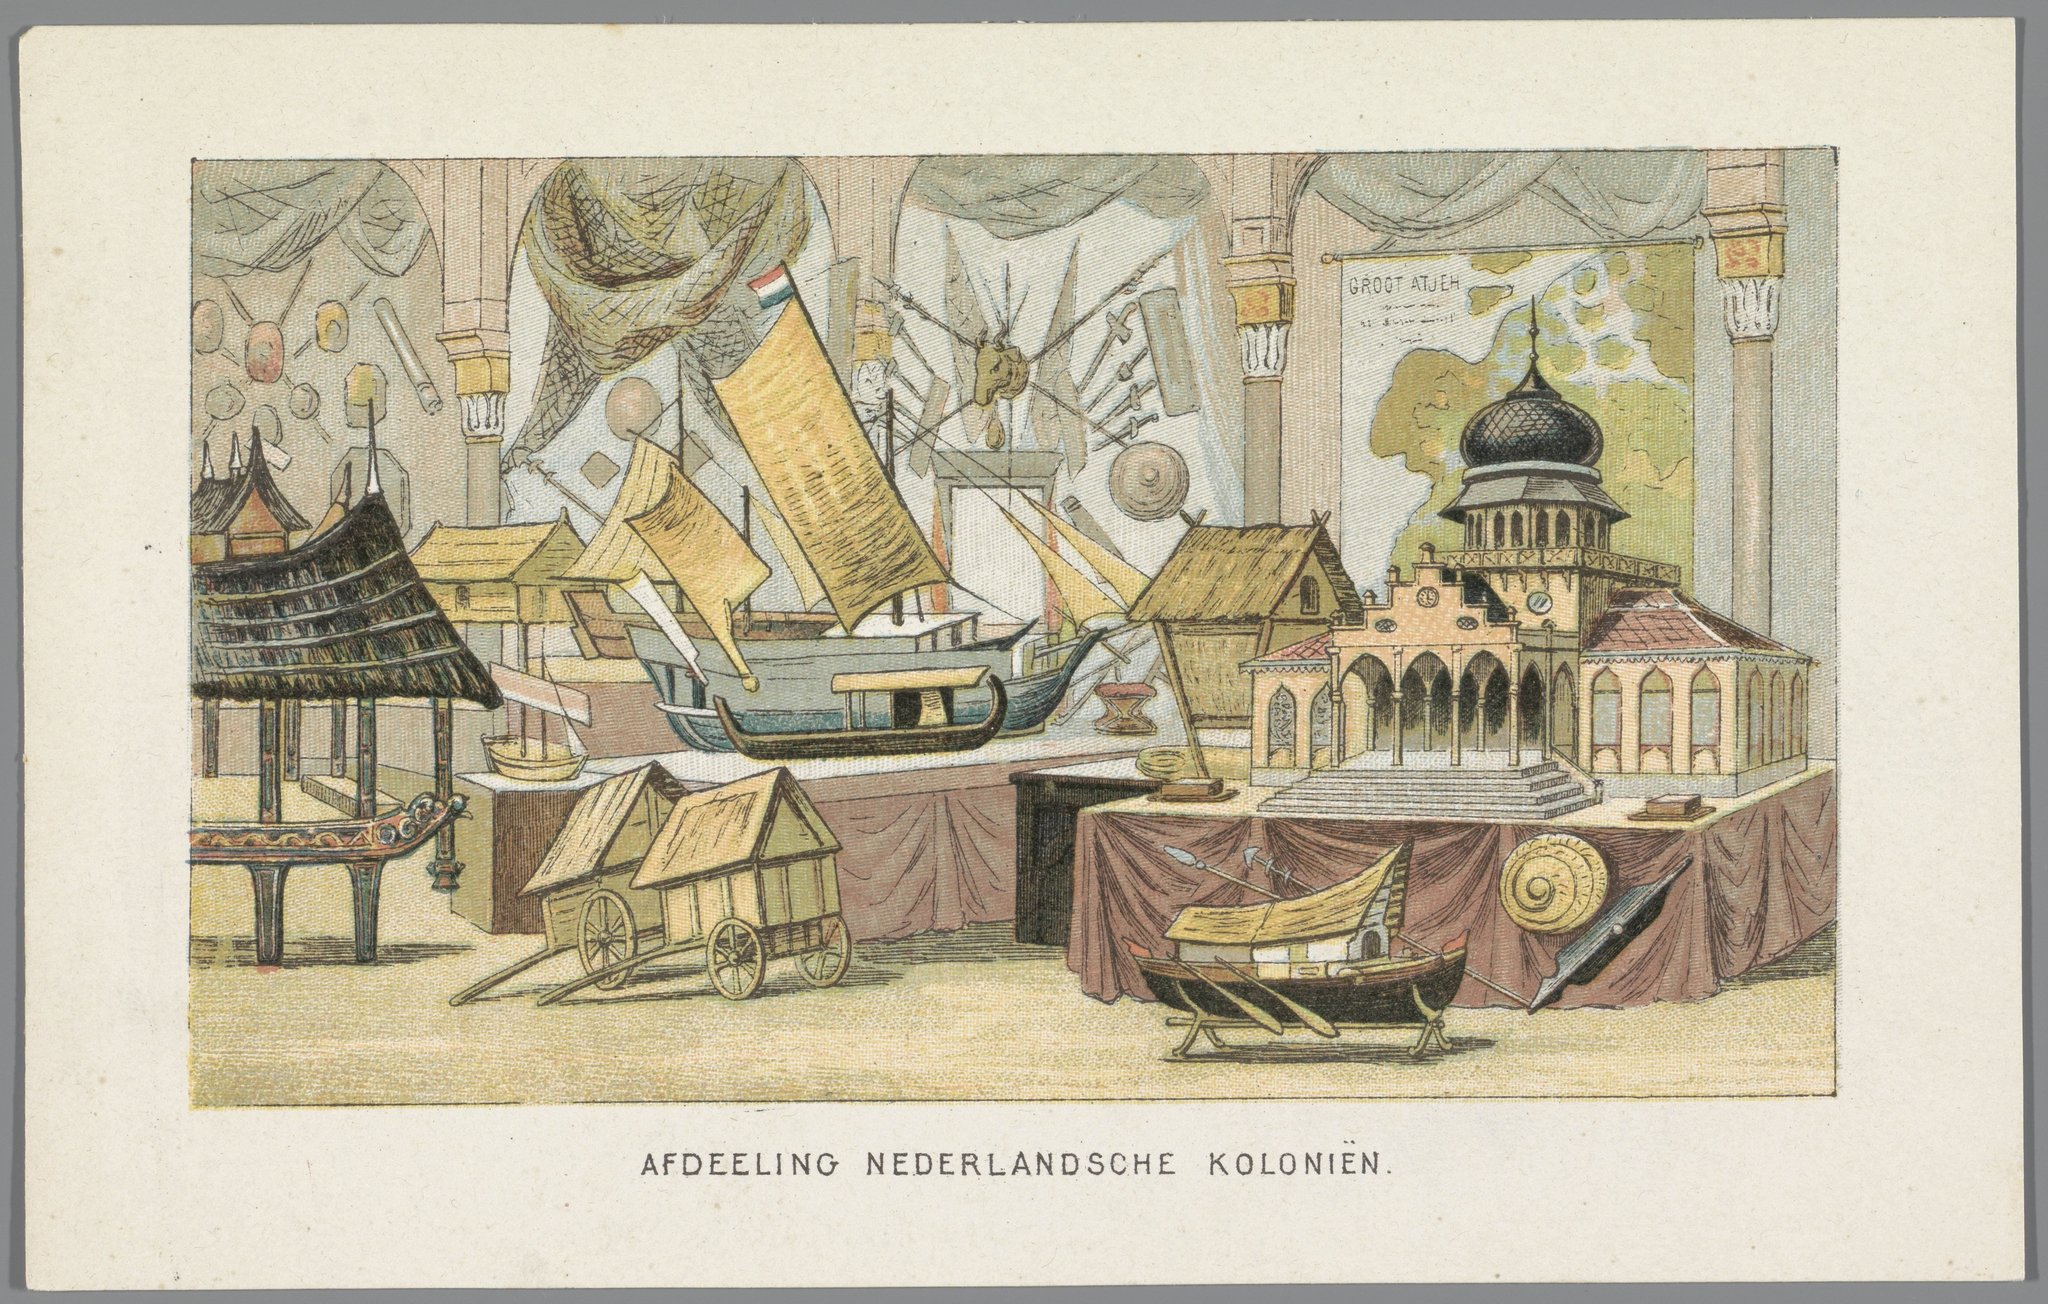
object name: print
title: In het gebouw van de Nederlandse koloniën op de Wereldtentoonstelling in Amsterdam, 1883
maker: Anonymous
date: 1883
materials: paper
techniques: chromolithography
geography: netherlands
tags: world fair, world exhibition, amsterdam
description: Verschillende tentoongestelde objecten in het gebouw voor de afdeling Nederlandse koloniën op de Wereldtentoonstelling op het Museumplein te Amsterdam. Onderdeel van een groep van zestien platen en een plattegrond van de Wereldtentoonstelling in Amsterdam van 1 mei tot 1 oktober 1883. Uitgave van het Nieuws van den Dag.